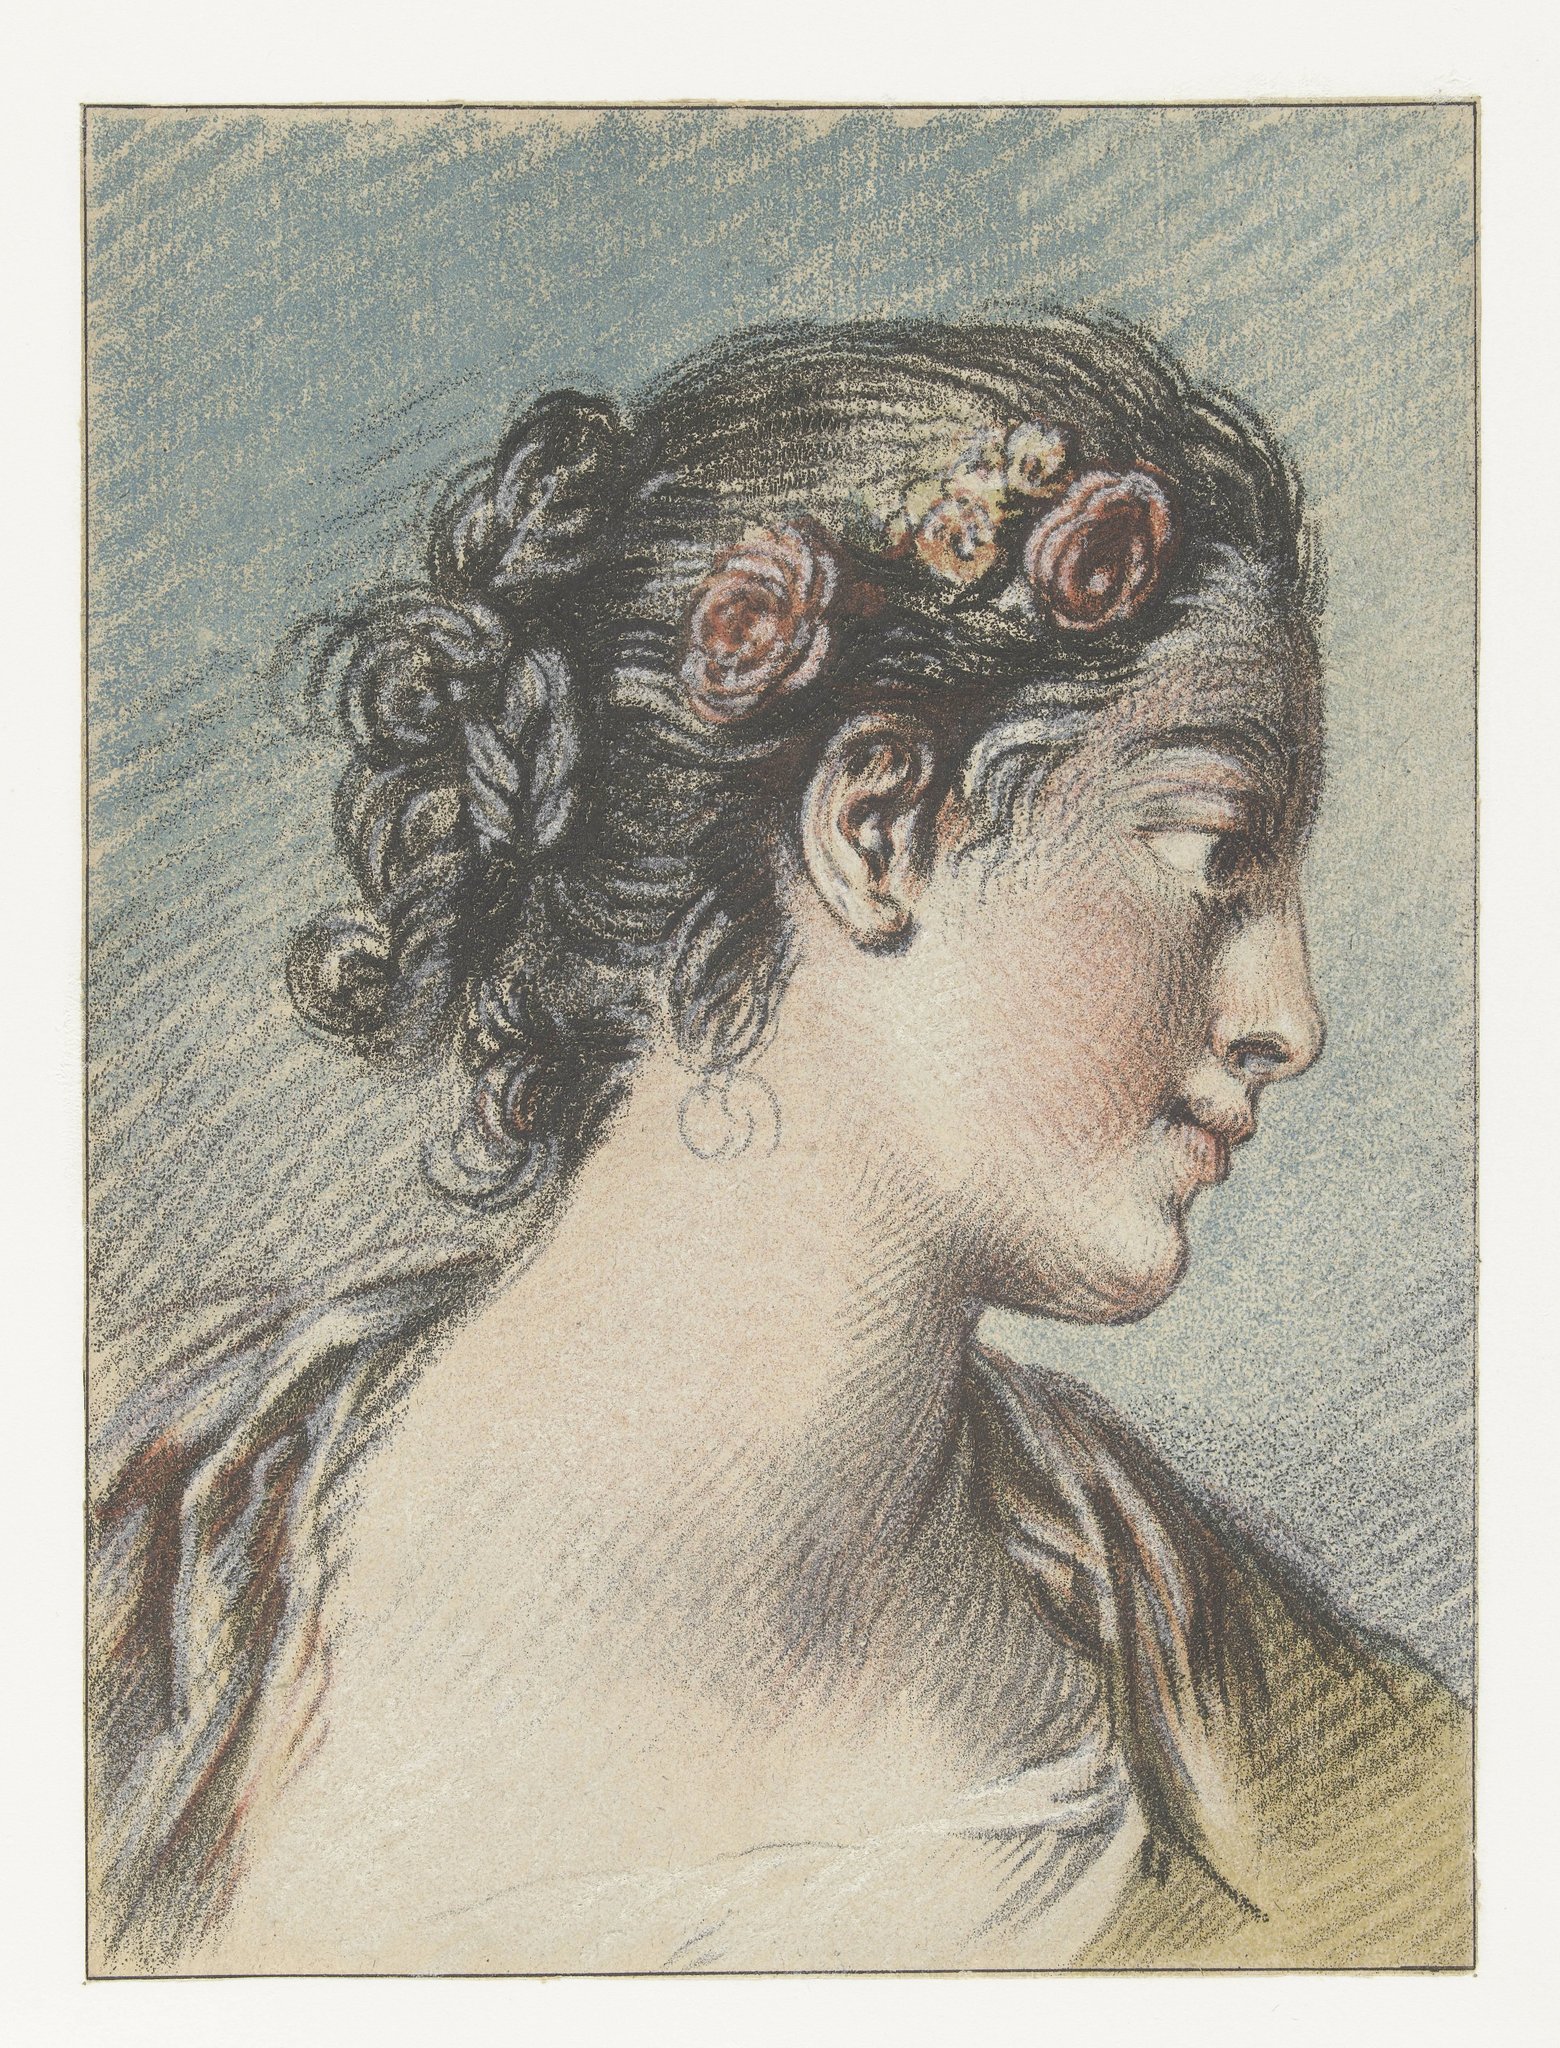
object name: print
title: Buste van een jonge vrouw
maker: louis marin bonnet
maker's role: print maker, publisher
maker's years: 1736-1793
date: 1768-1769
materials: paper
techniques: printing, printmaking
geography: france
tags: adolescent, young woman, maiden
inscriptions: collector's mark: Lugt 2228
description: Buste van een jonge vrouw met bloemen in het haar.